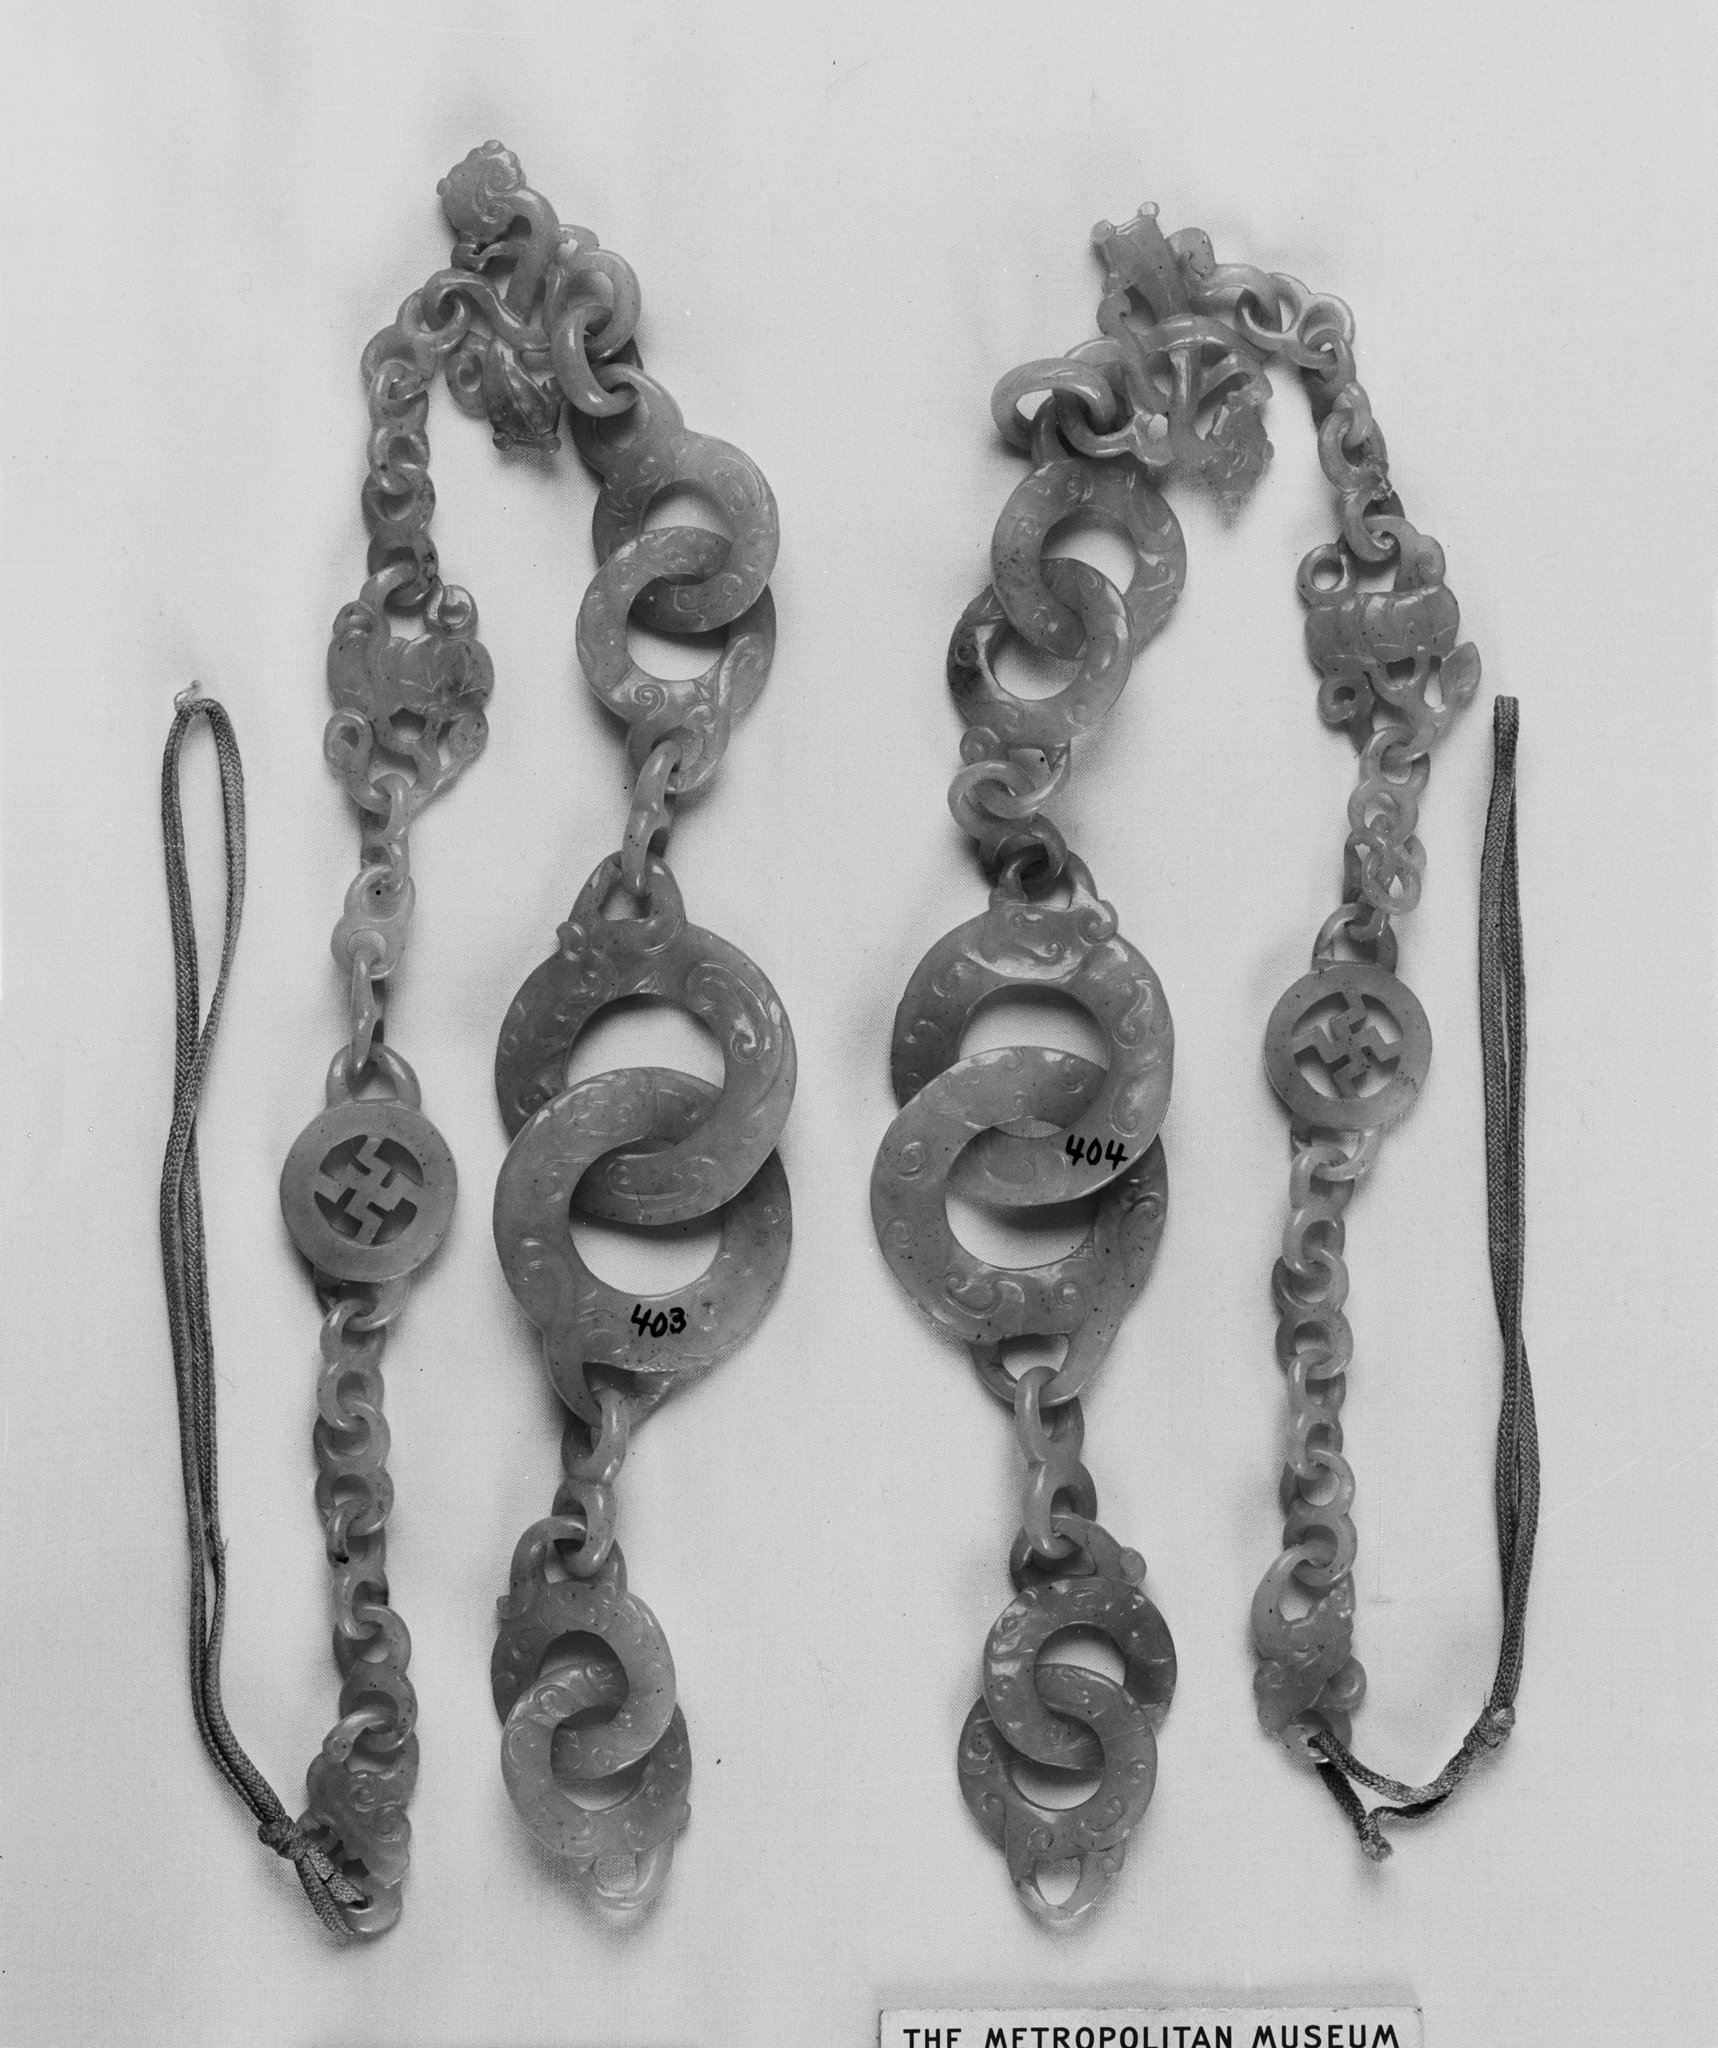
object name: chain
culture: chinese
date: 1368-1644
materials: jade